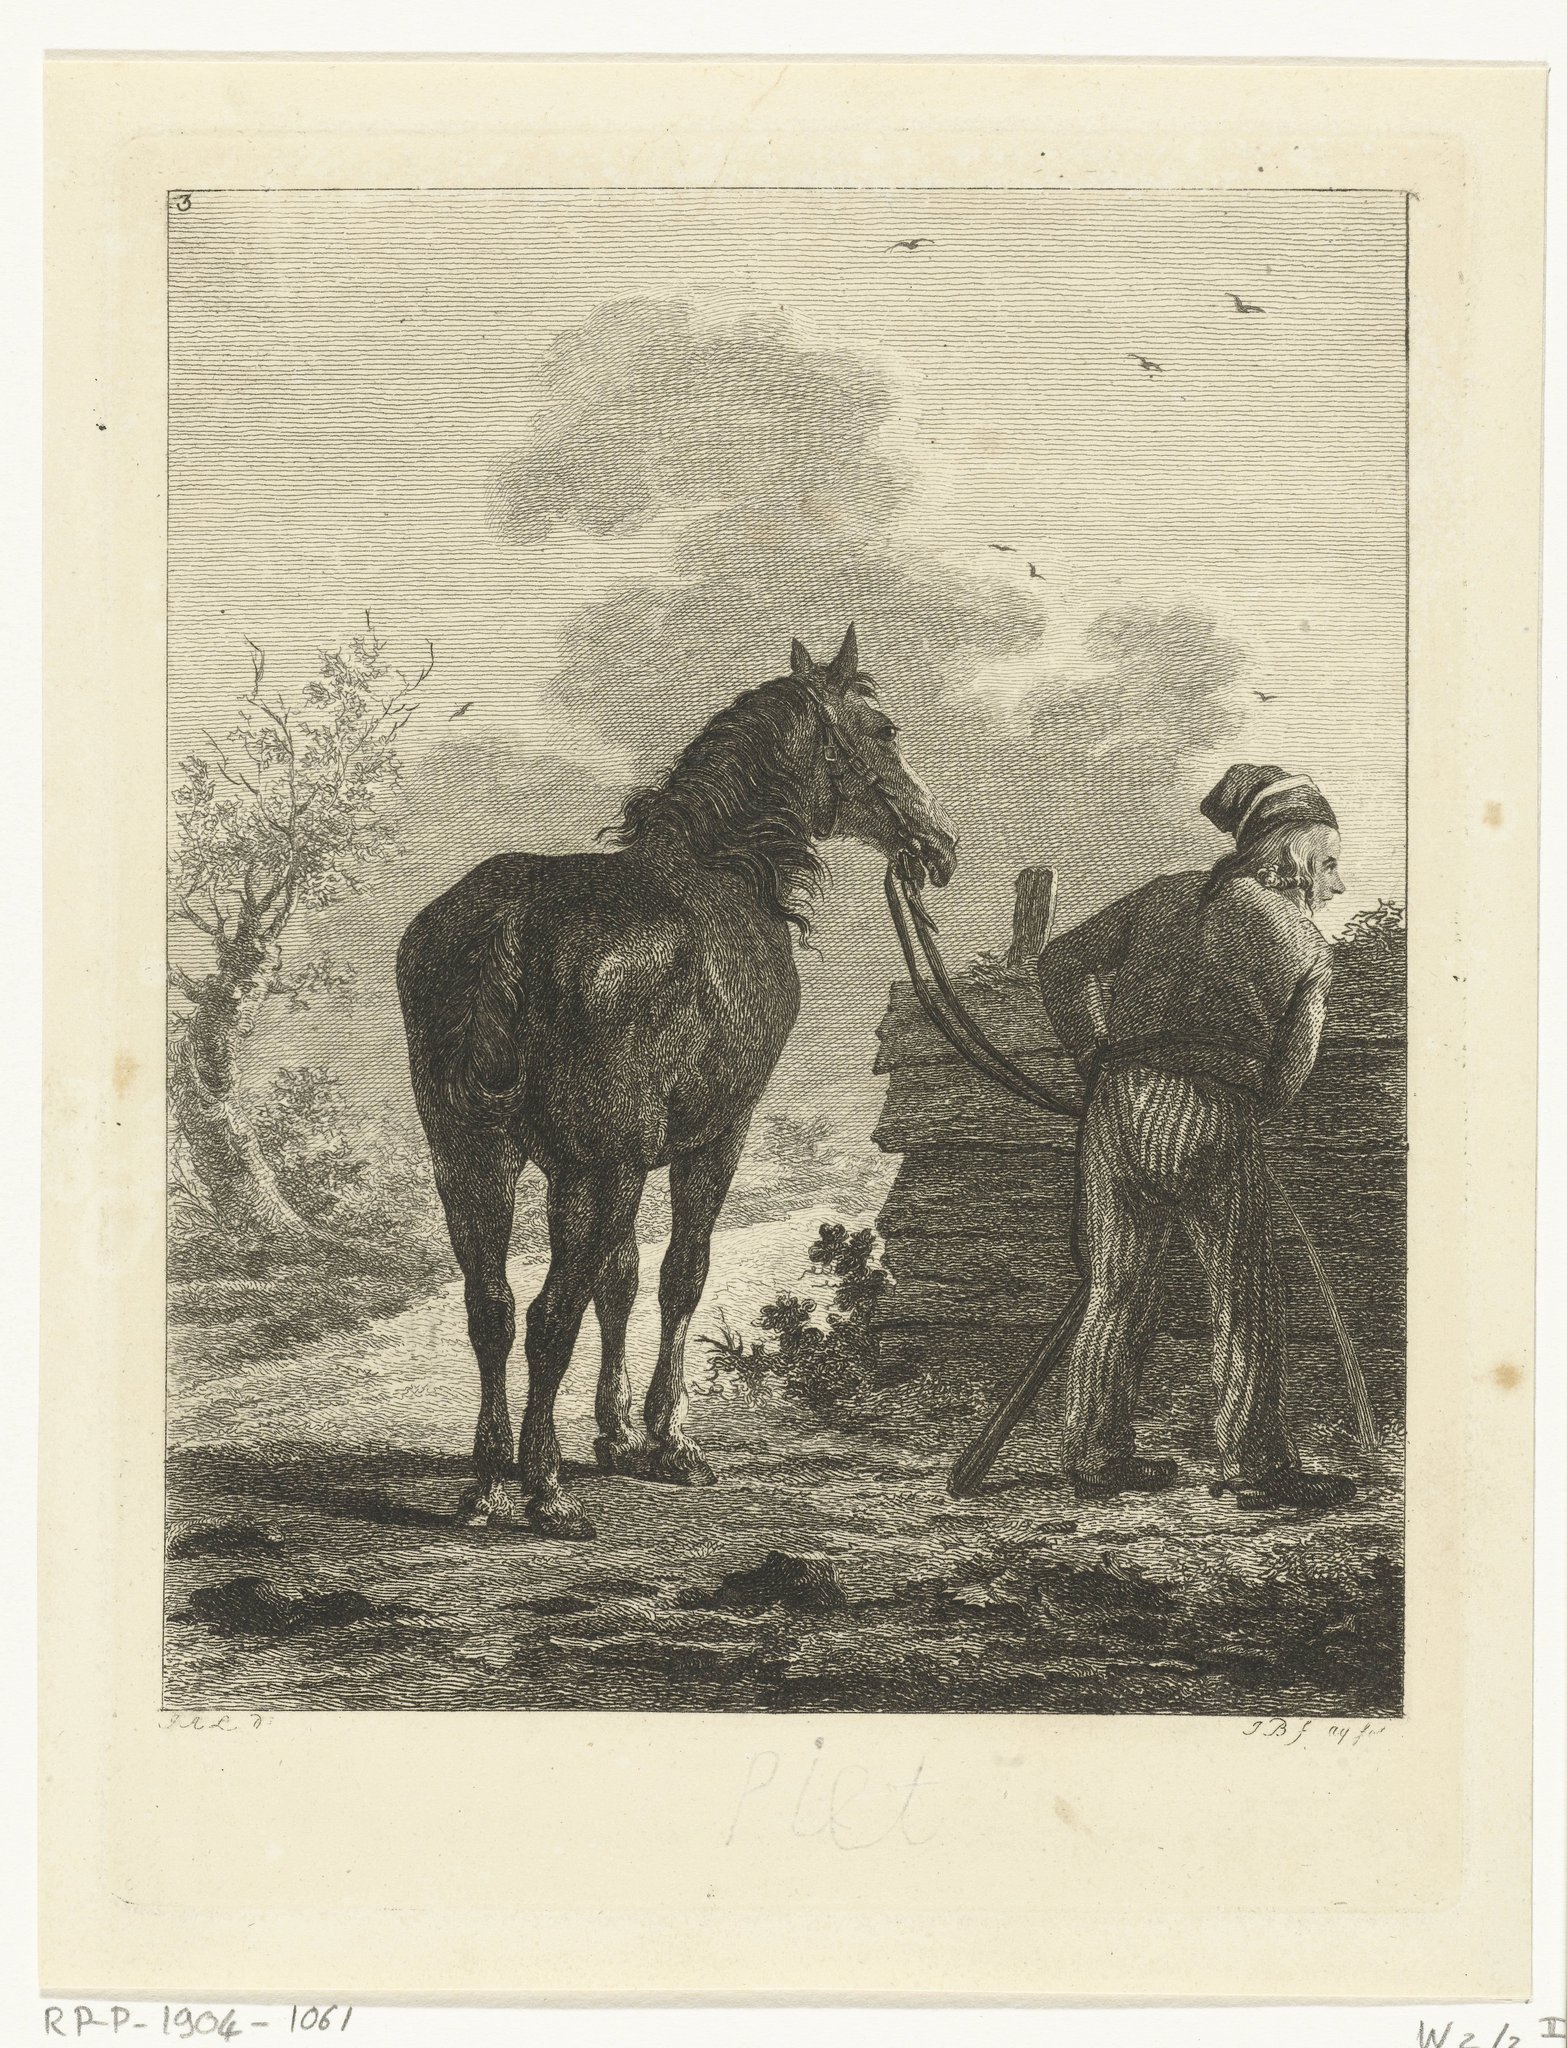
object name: print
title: Pissende man met paard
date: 1802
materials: paper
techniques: etching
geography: rotterdam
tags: horse, occupations ~ cattle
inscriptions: collector's mark: Lugt 2228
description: Een man pist tegen een schutting, met zijn hand houdt hij de teugels van een paard vast.